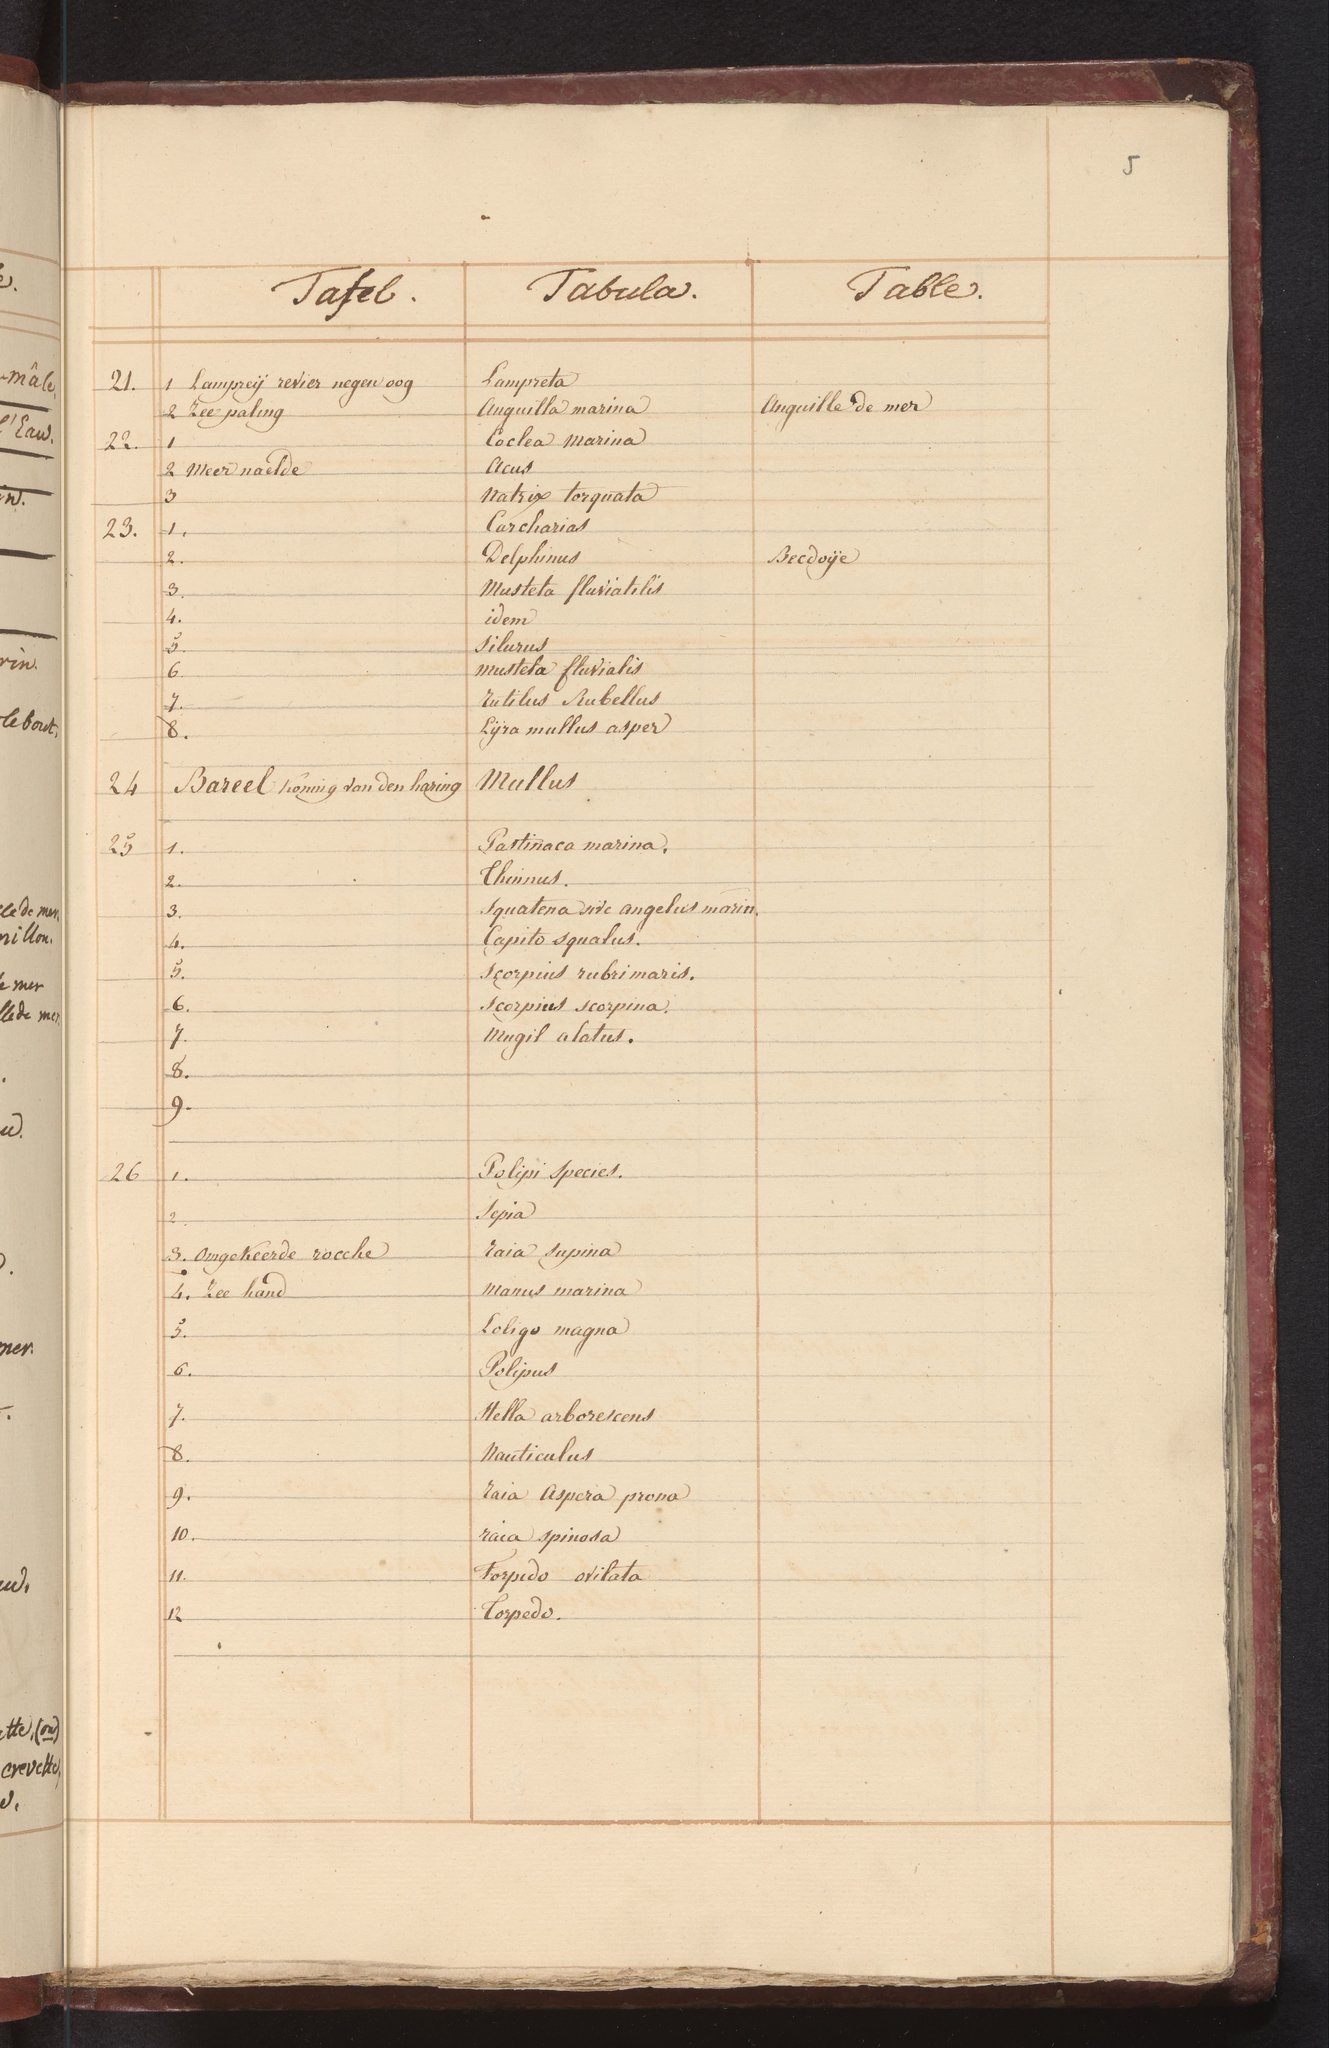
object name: manuscript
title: Lijst van vissen in het eerste deel van de zeevissen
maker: joseph van huerne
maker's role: kunstliefhebber, mecenas, verzamelaar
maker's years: 1752-1844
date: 1809-1814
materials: ink, paper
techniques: handwriting, pen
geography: bruges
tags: handwriting, written text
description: Schema met een lijst van de vissen voorgesteld in het eerste deel van de zeevissen: nummers 21-26. Onderdeel van het zesde album met tekeningen van vissen, schelpen en insekten. Zesde van twaalf albums met tekeningen van dieren, vogels en planten bekend rond 1600, gemaakt in opdracht van keizer Rudolf II. Met toelichting in Nederlands, Latijn en Frans.